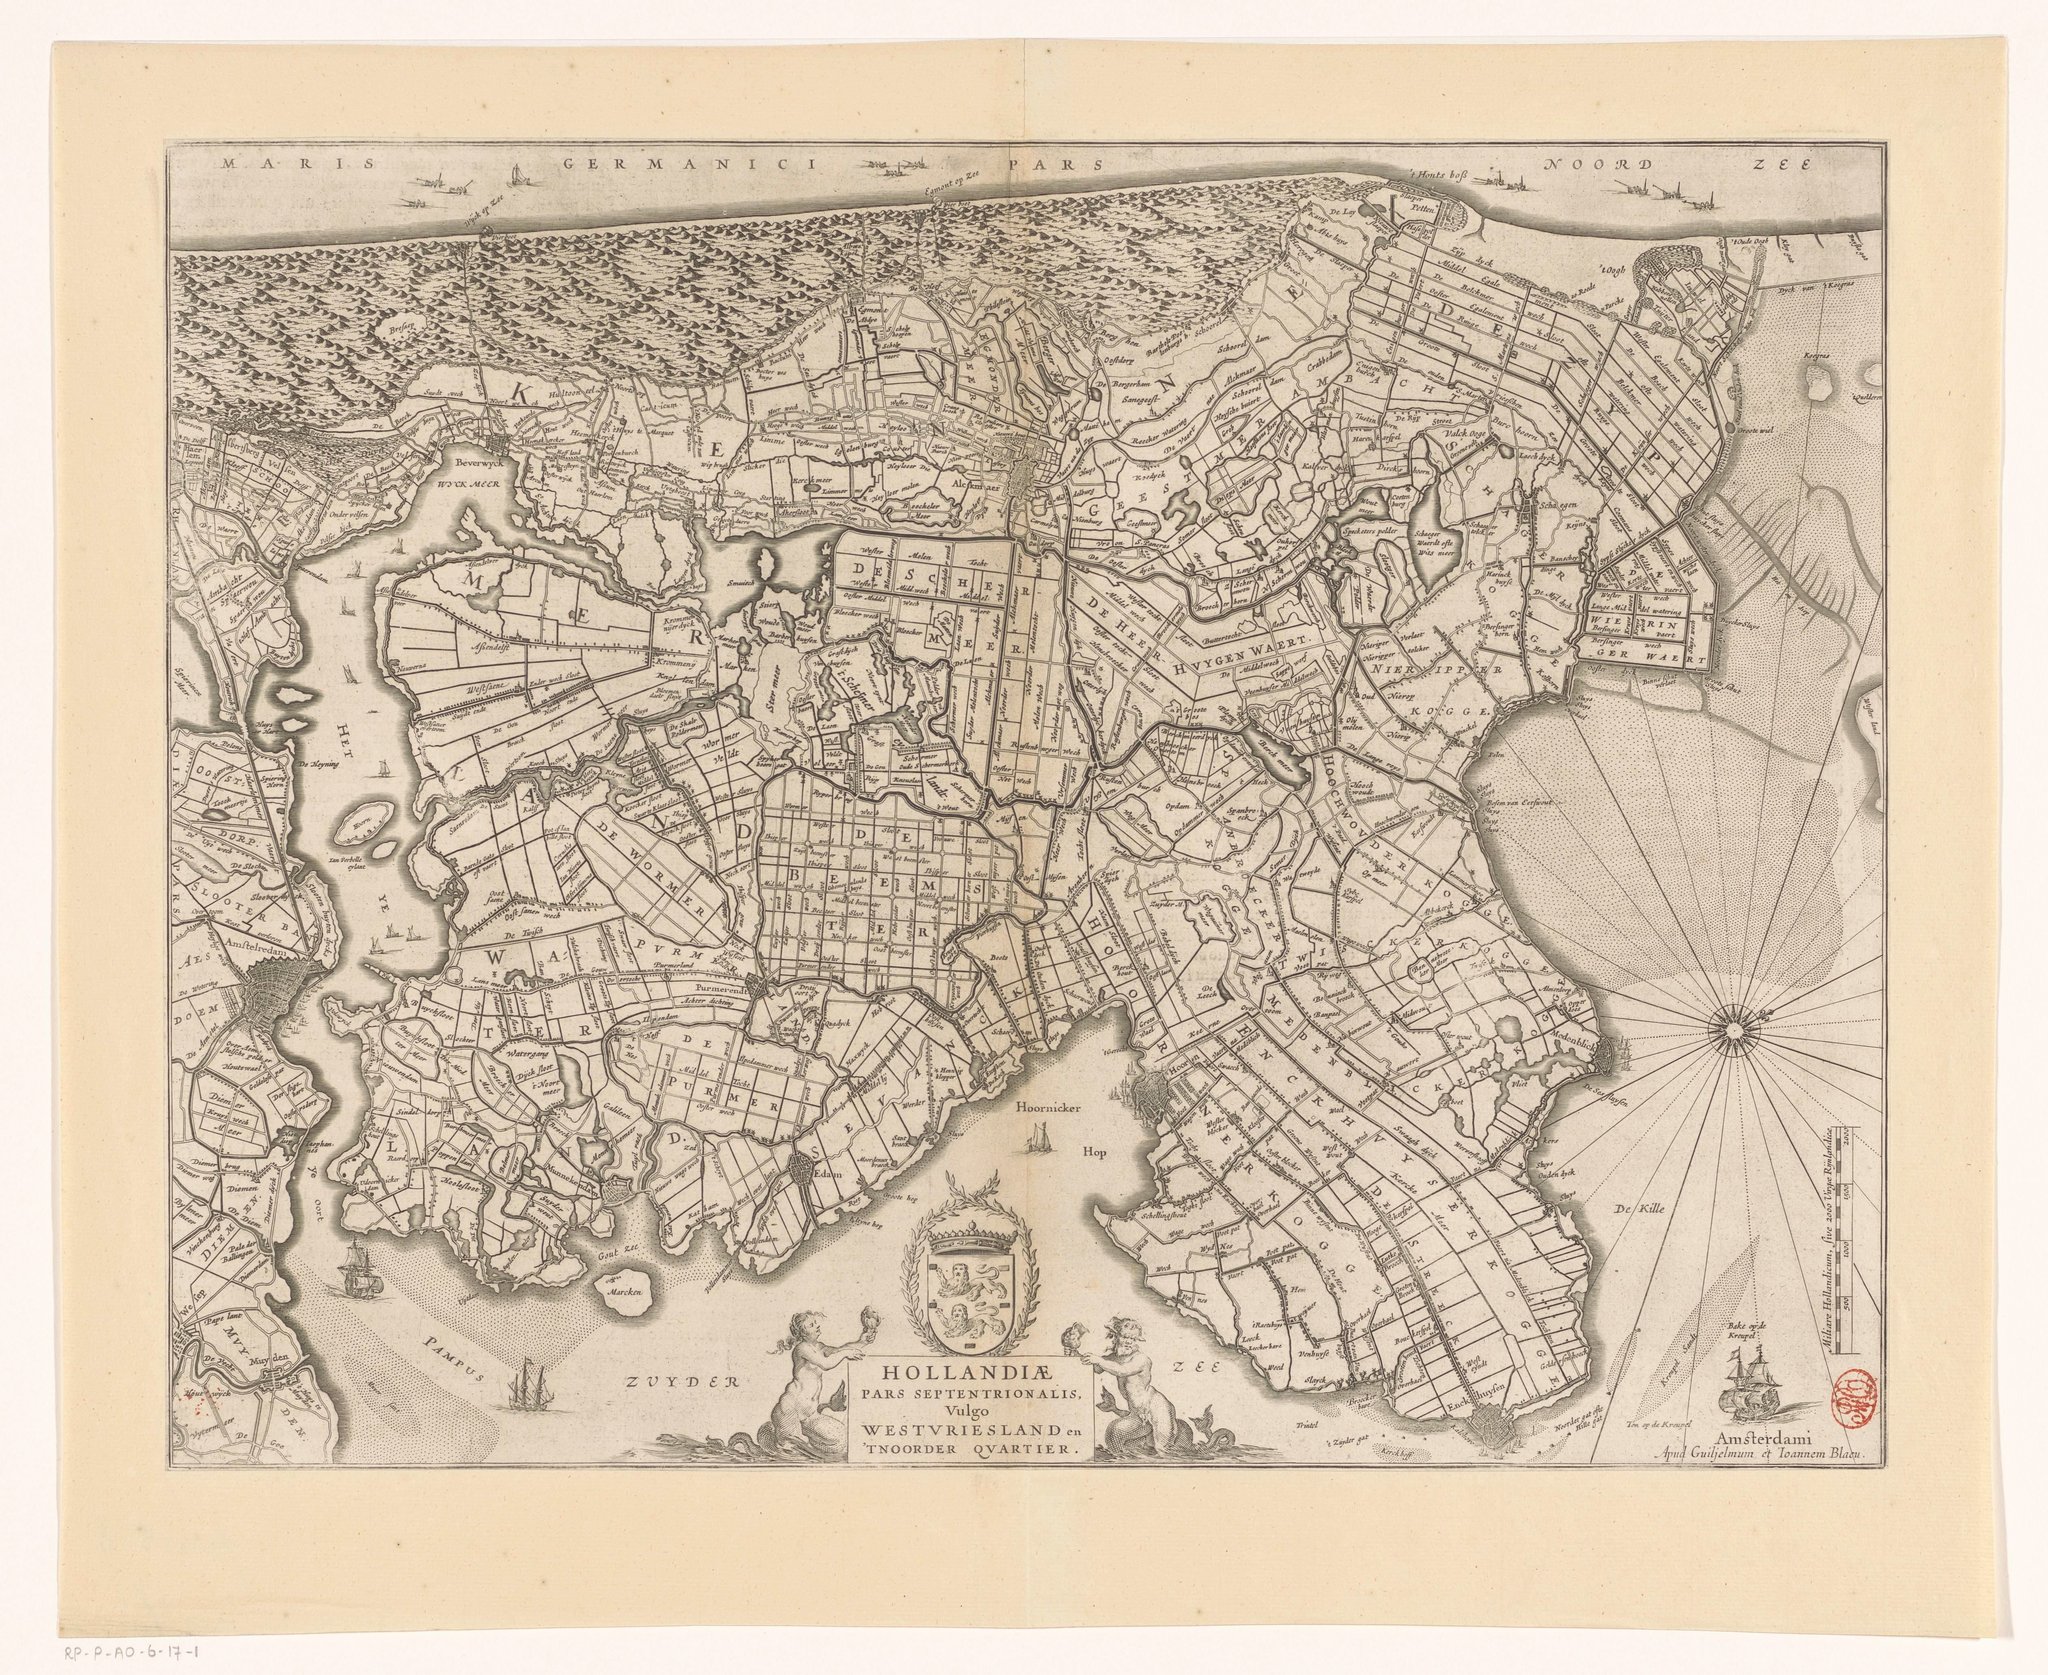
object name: map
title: Hollandiae pars septentrionalis, vulgo Westvriesland en ’t Noorder quartier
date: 1662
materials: paper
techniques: engraving, etching, letterpress printing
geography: amsterdam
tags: coat of arms (as symbol of the state, etc.), triton(s), maps of separate countries or regions, merman - aa - mermaid, siren, holland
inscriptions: collector's mark: Lugt 195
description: Onderaan de titelcartouche met het wapen van West-Friesland in een lauwerkrans en een tweestaartige zeemeermin en een tweestaartige triton. Rechtsonder een schaalstok: Miliare Hollandicum, sive 2000 virgae Rijnlandicae. Oriëntatie: noorden rechts. Op verso Latijnse tekst.